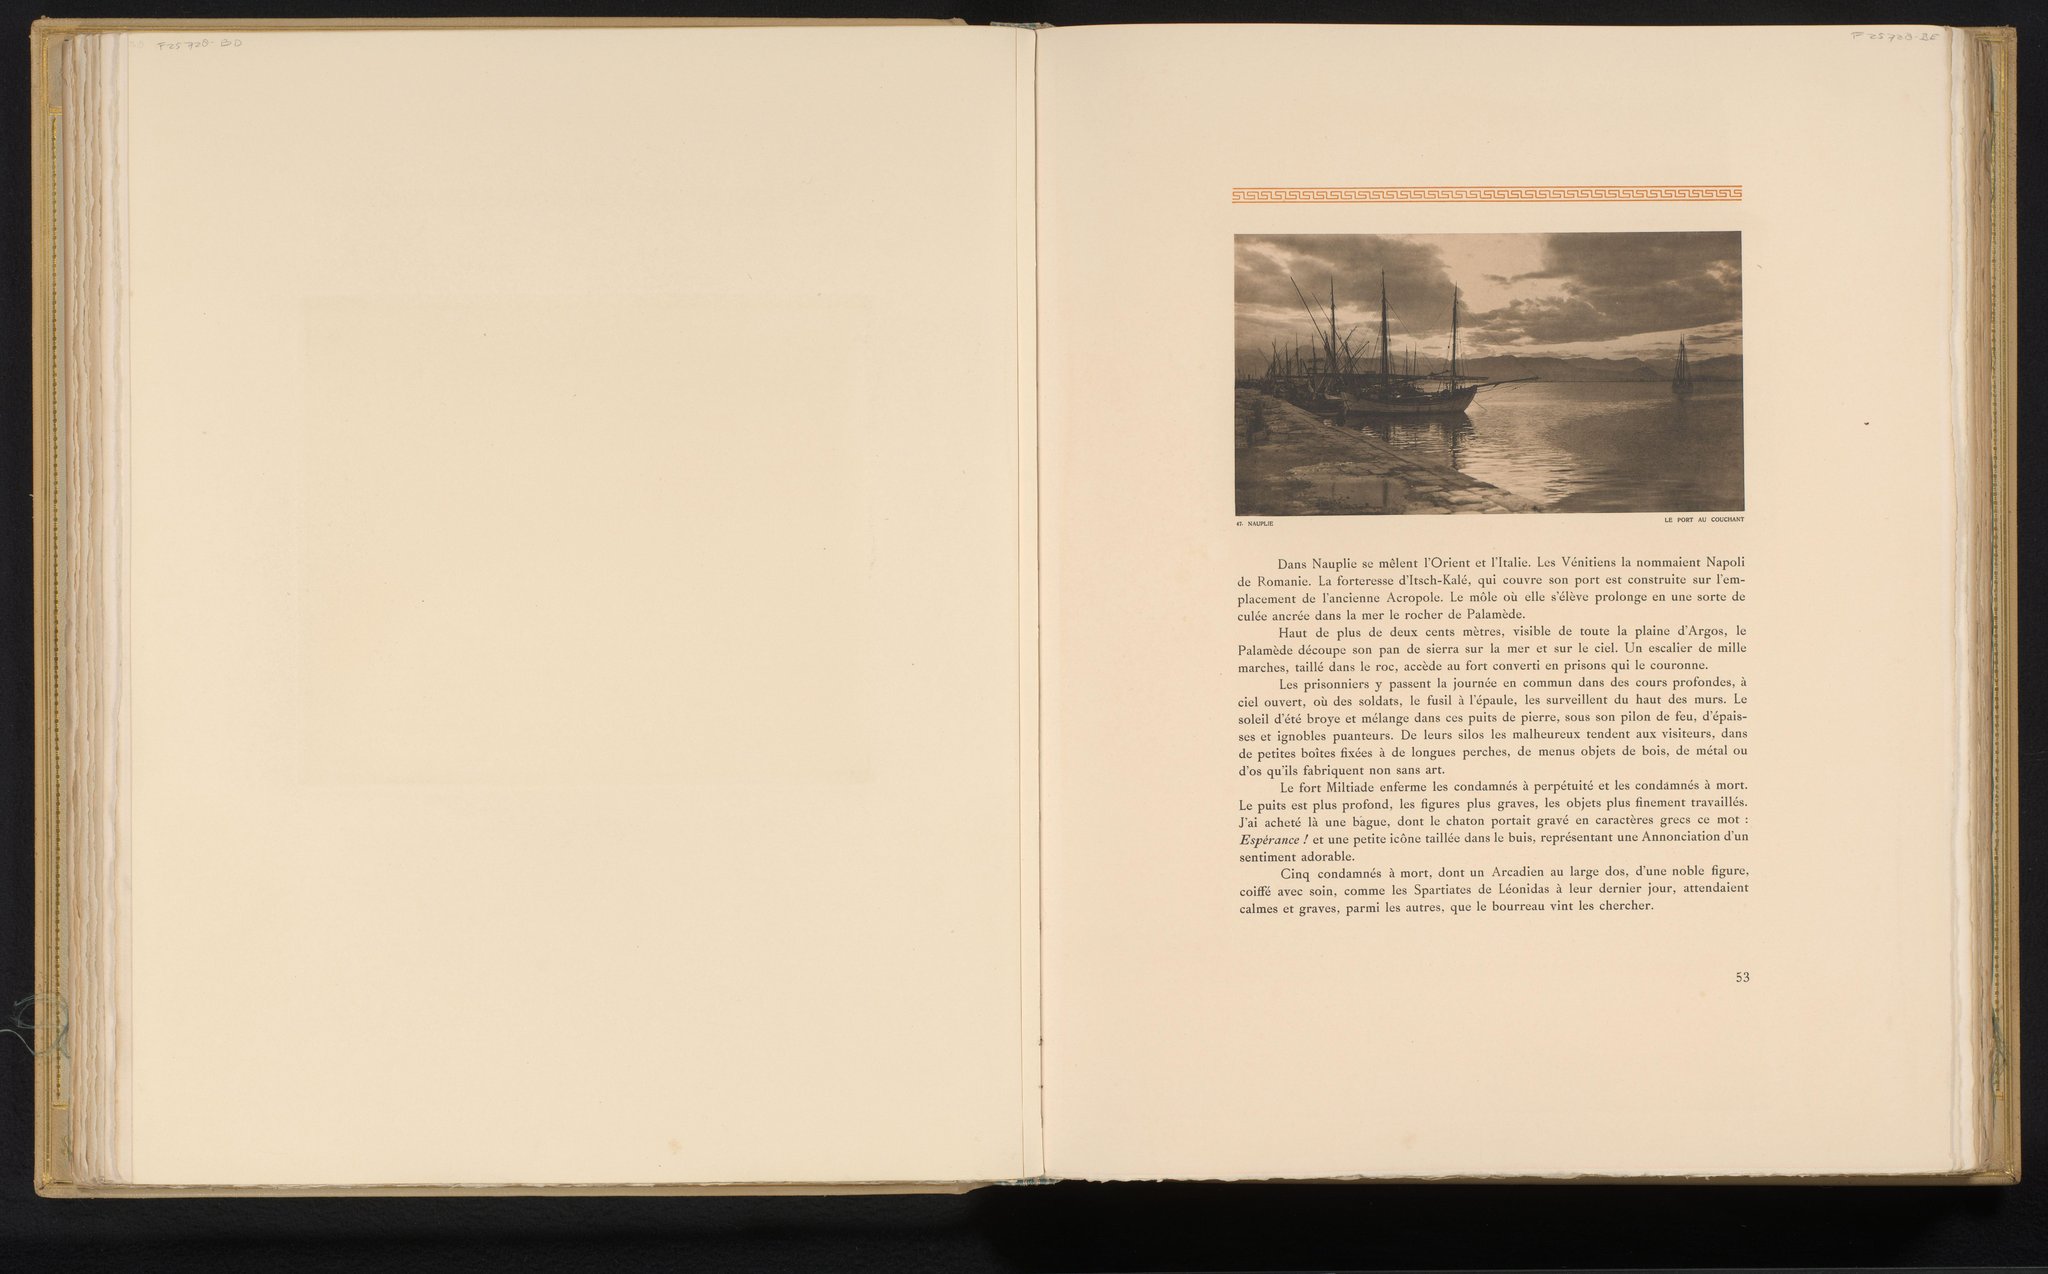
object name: photomechanical print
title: Nauplie, le port au couchant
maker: frédéric boissonnas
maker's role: fotograaf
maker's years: 1858-1946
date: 1905-1910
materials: paper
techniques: photograph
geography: nauplion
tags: harbour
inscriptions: number: ‘47.’